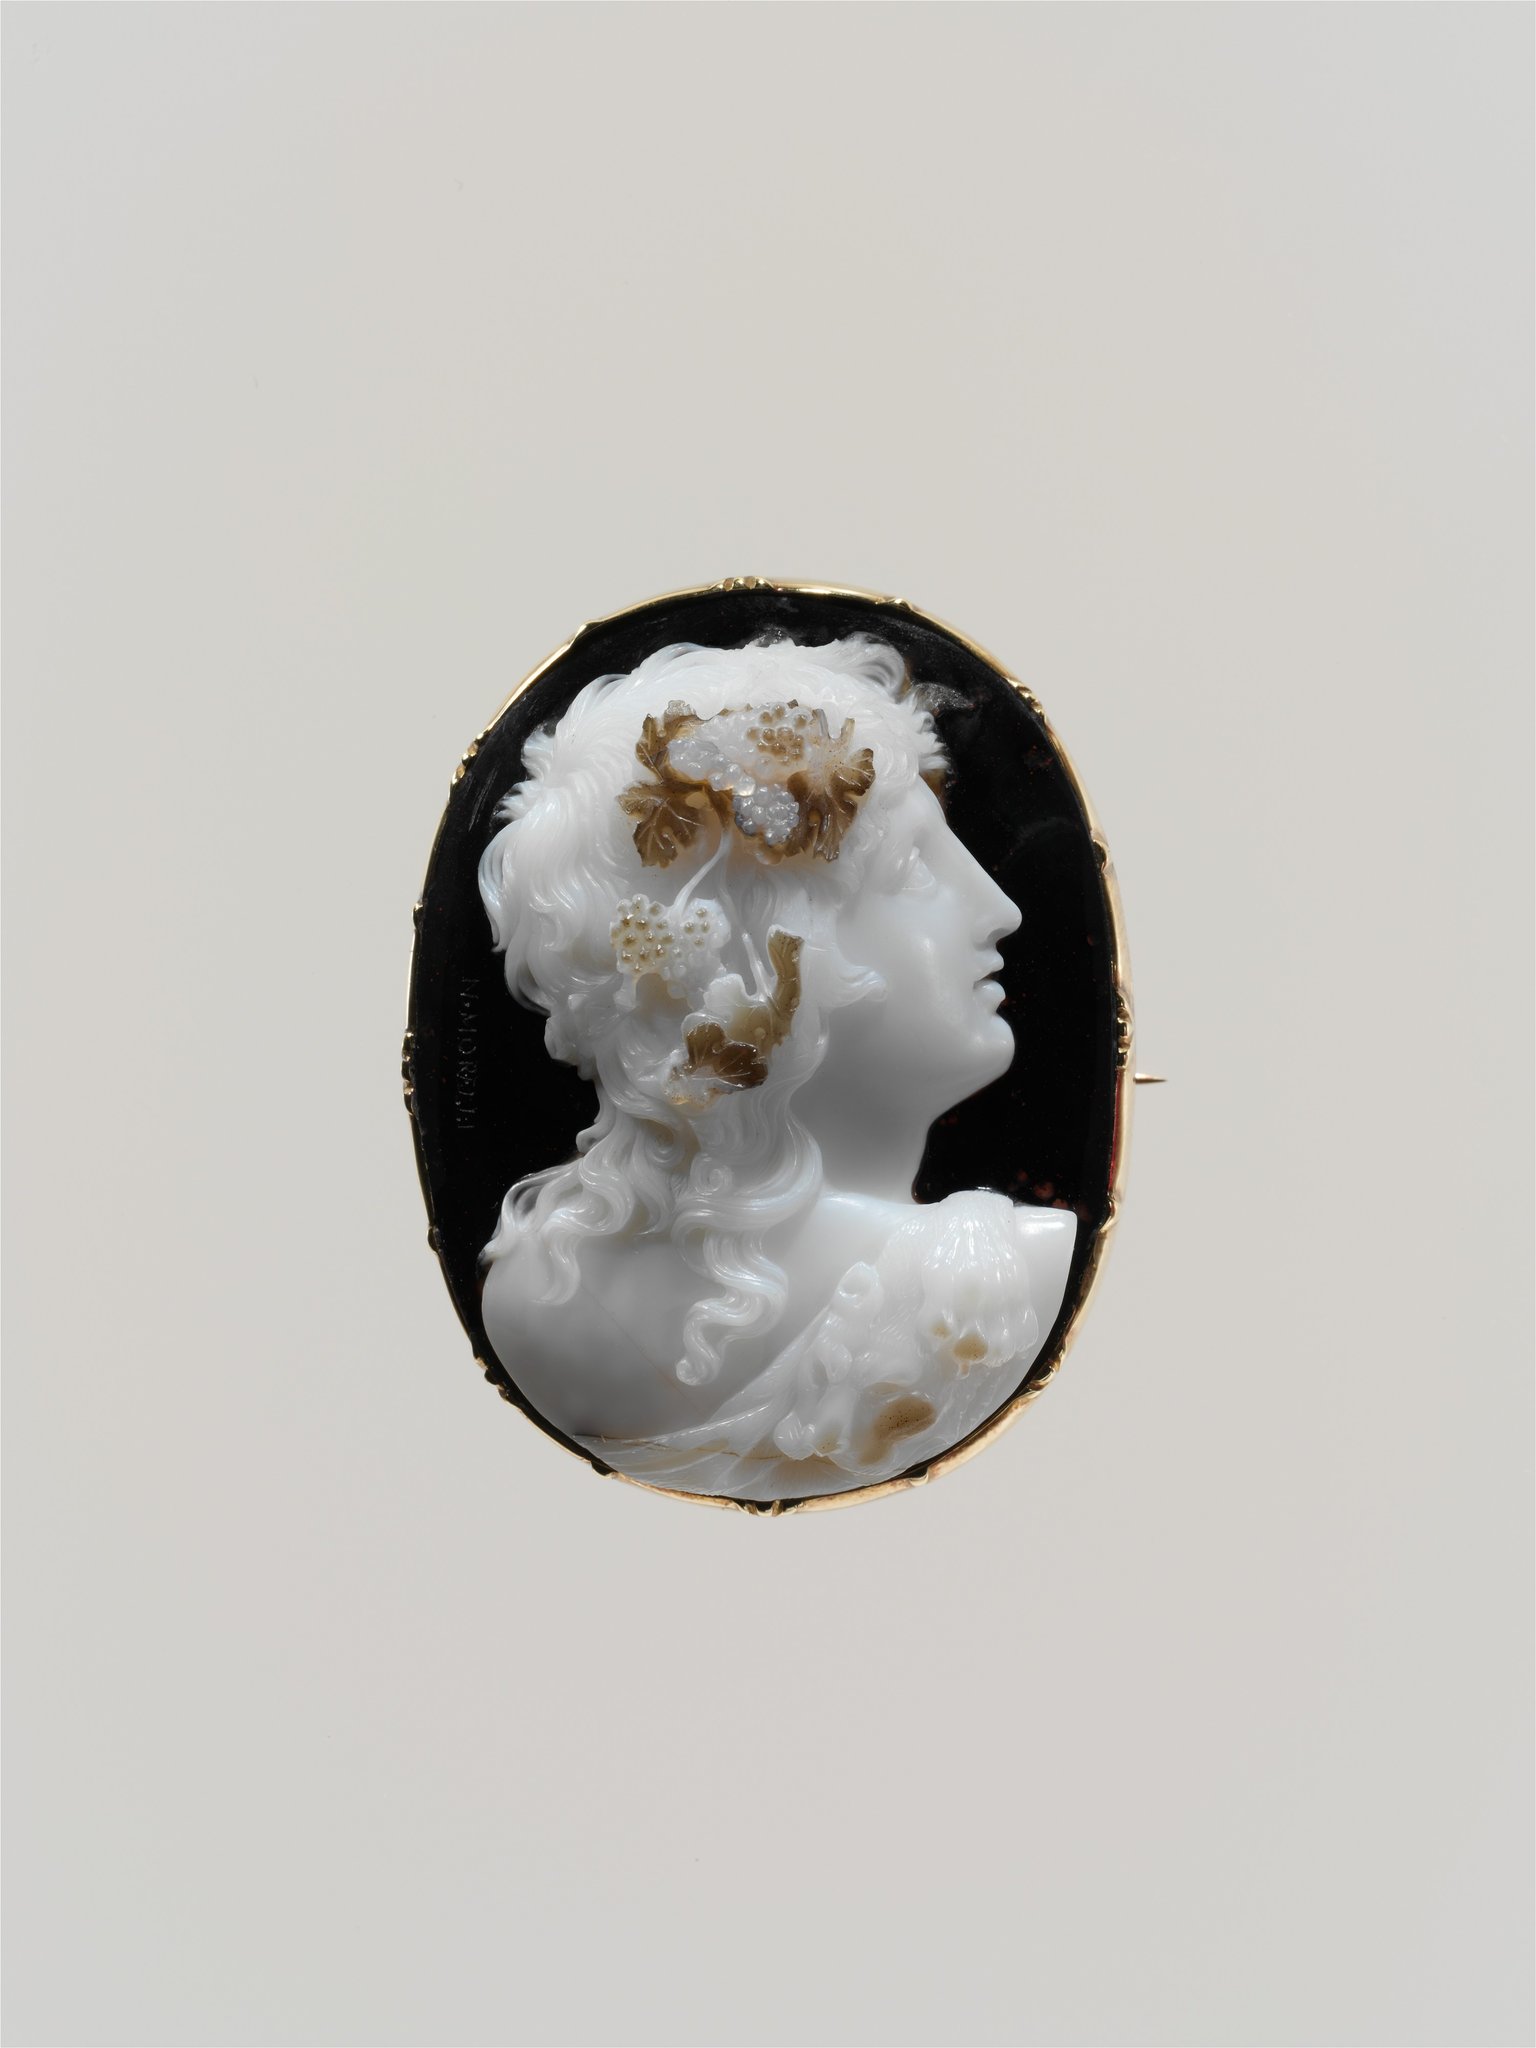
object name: cameo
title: Bust of a bacchante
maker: nicola morelli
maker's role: artist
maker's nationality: italian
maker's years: 1771-1838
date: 1820-1838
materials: onyx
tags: bacchantes